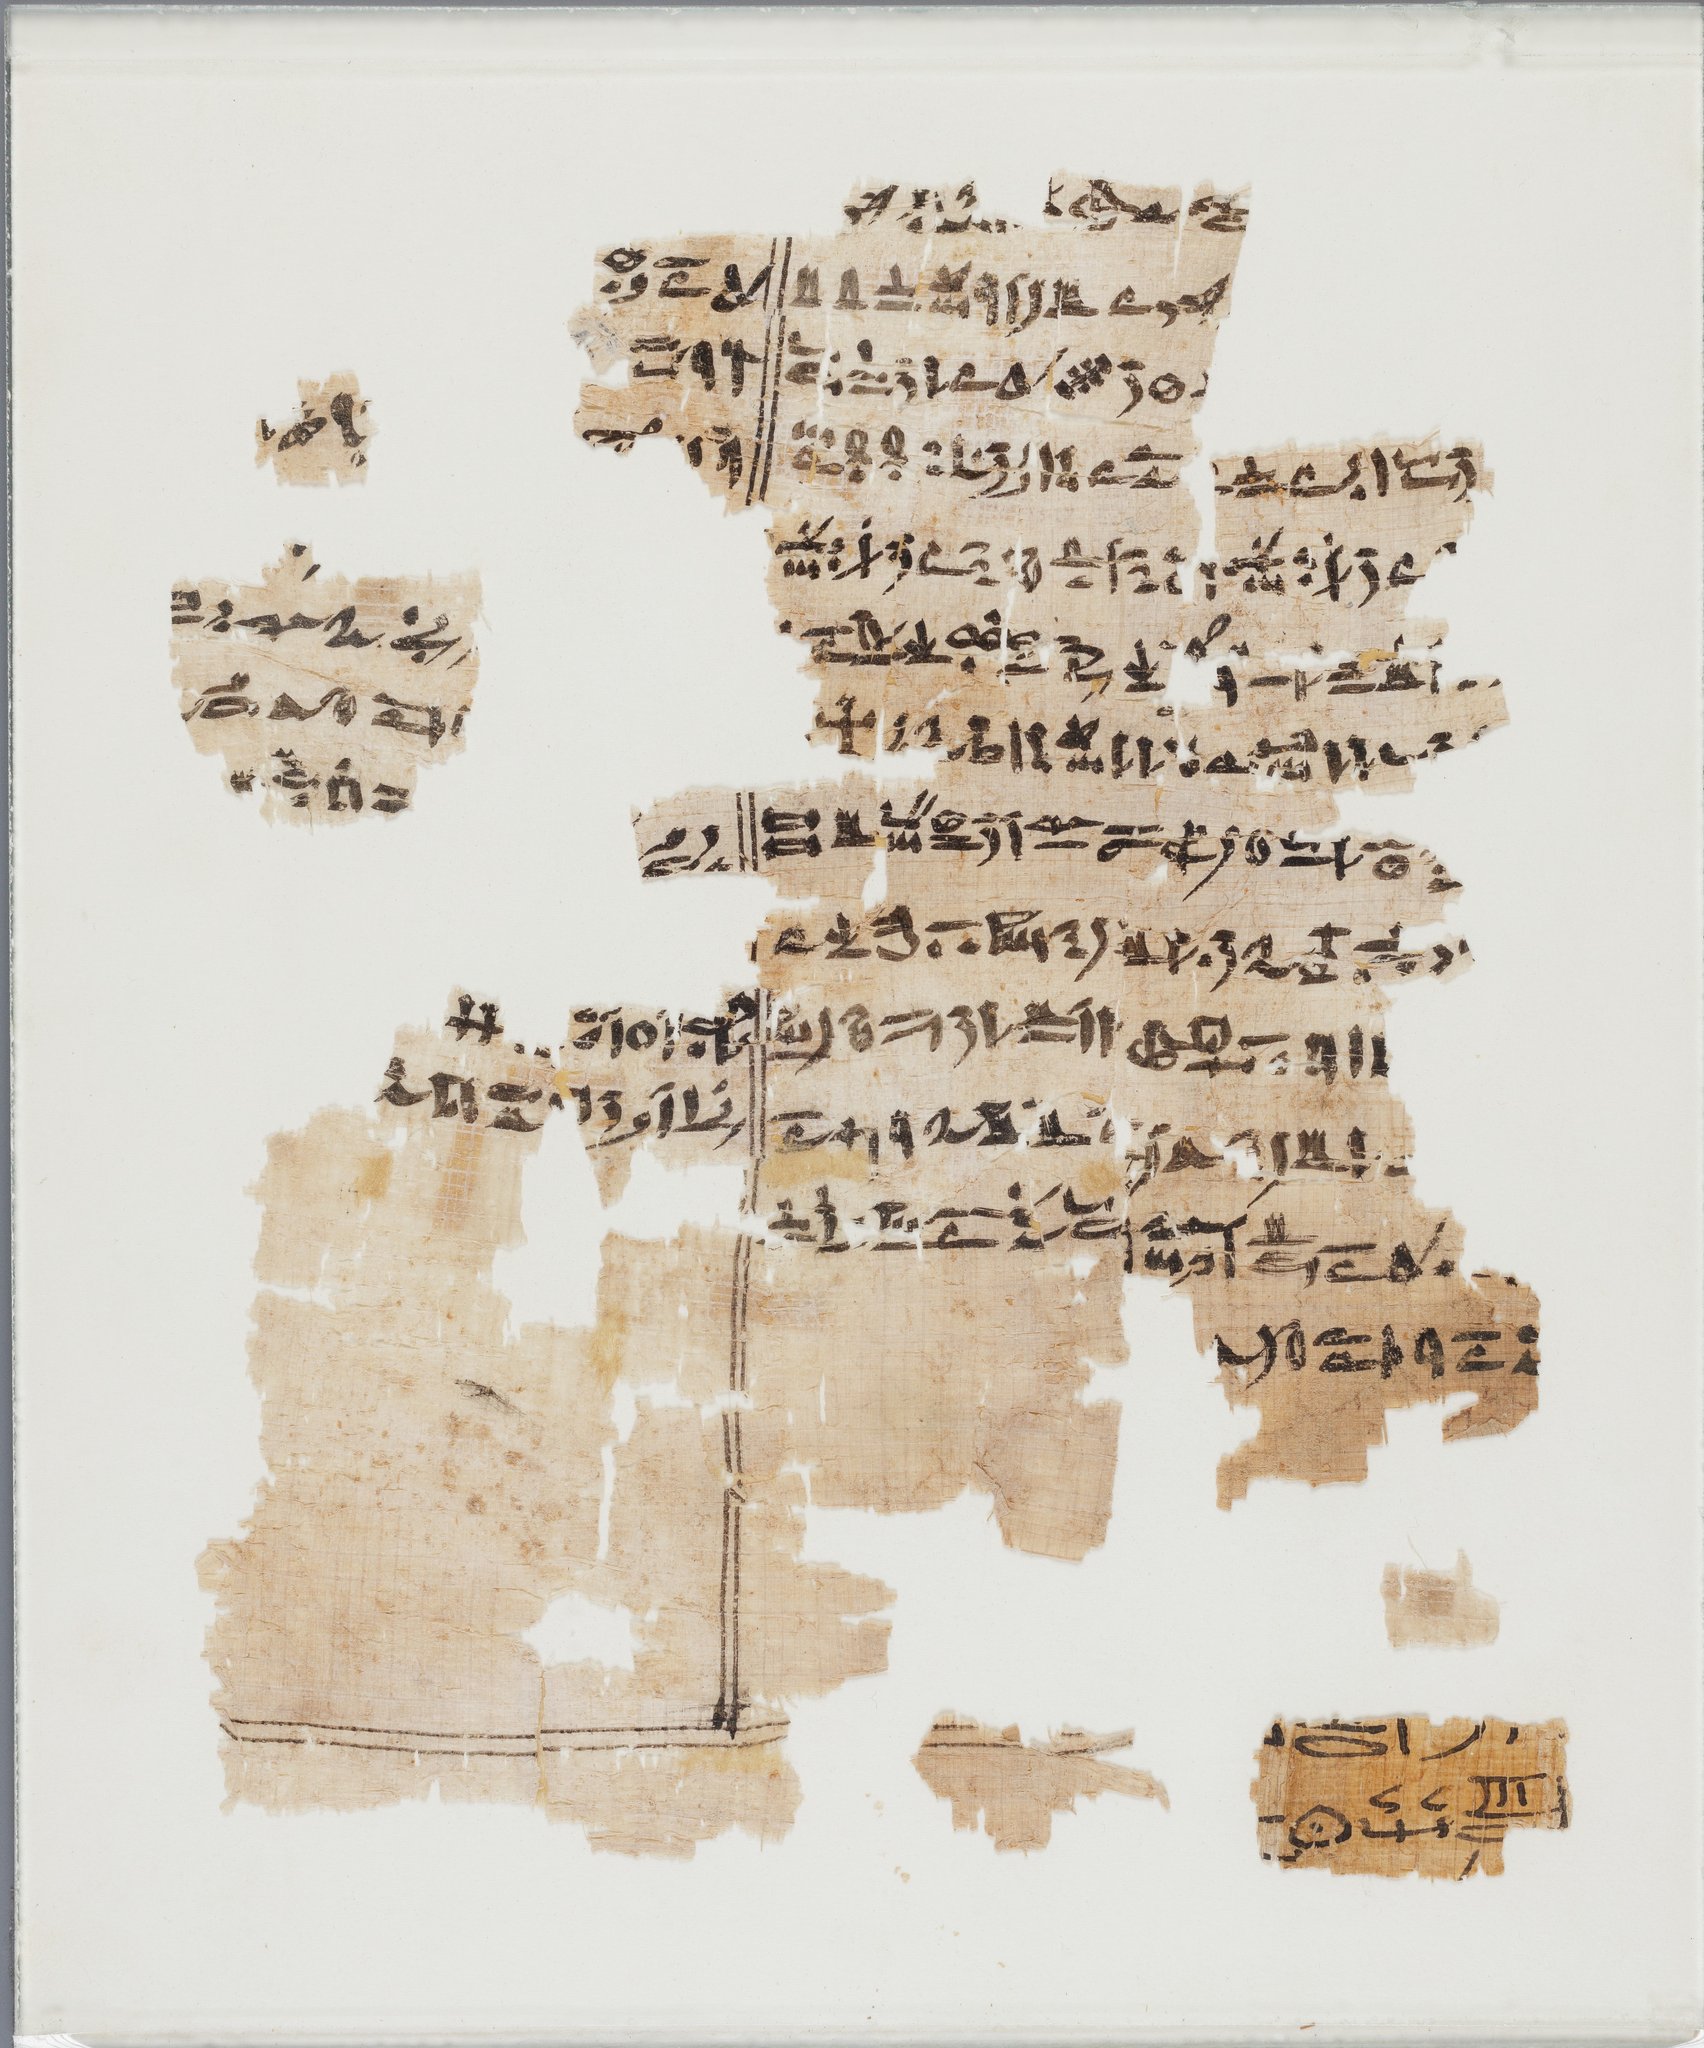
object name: papyrus, funerary, book of the dead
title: Fragments of the Book of the Dead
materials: ink, papyrus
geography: egypt